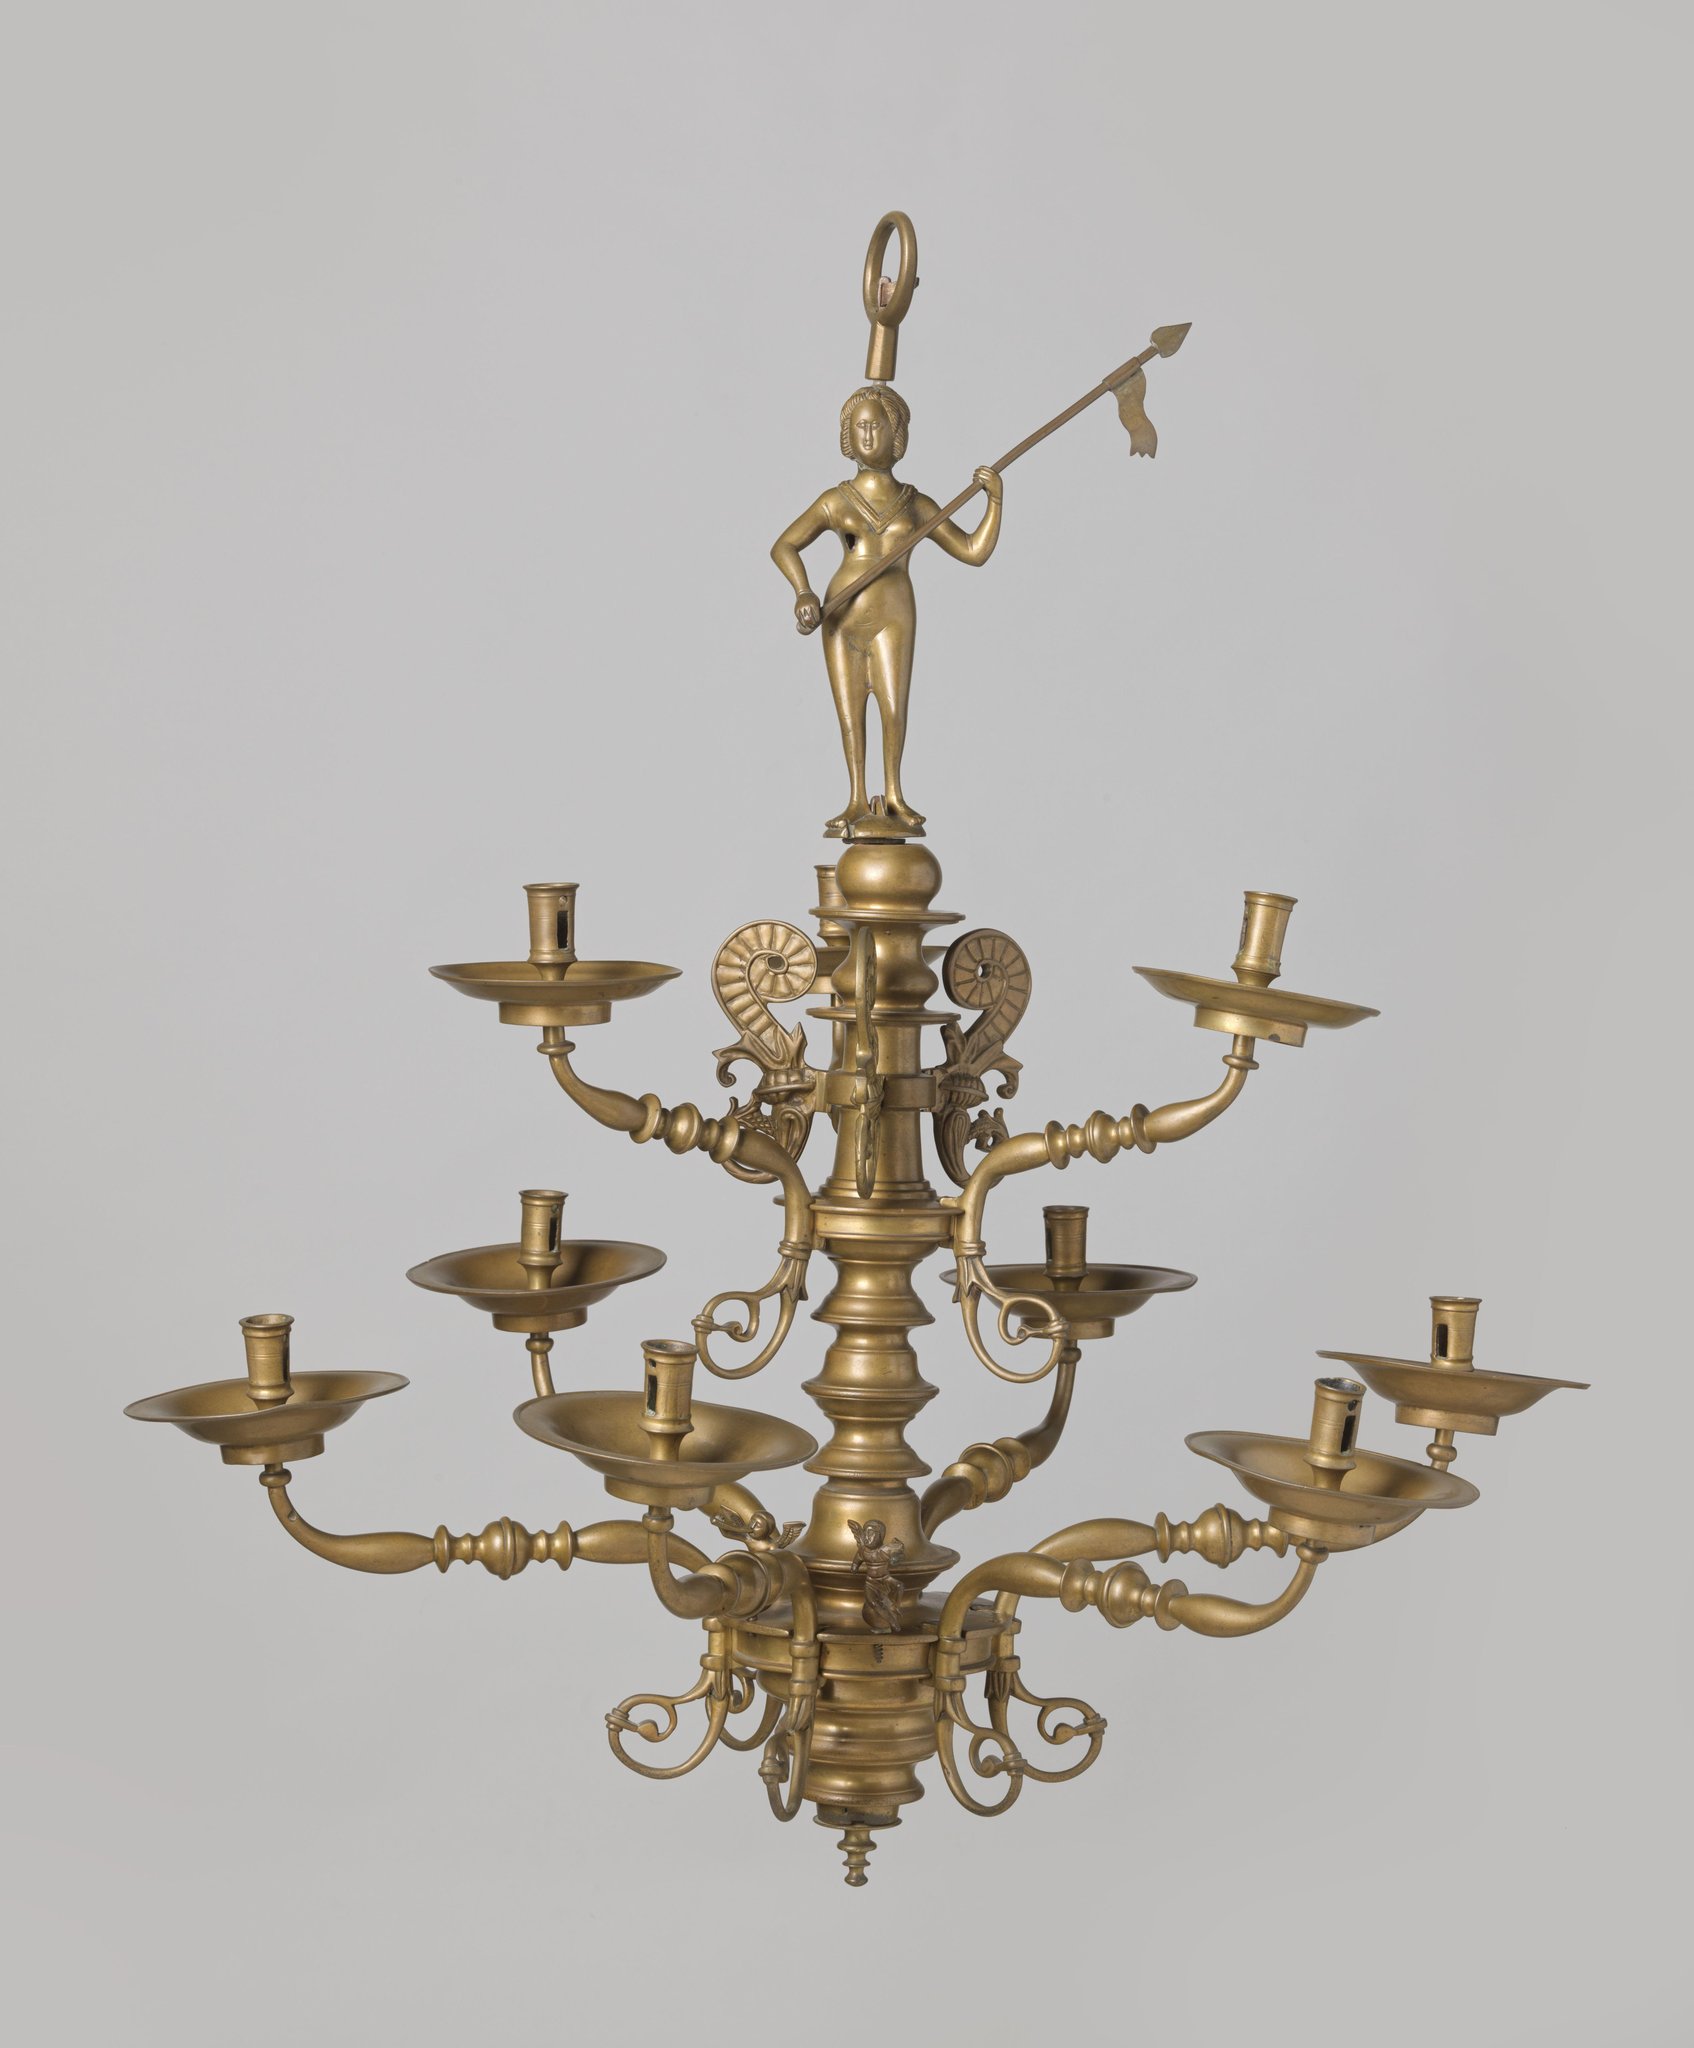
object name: chandelier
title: Arm met kaarsenhouder van kaarsenkroon van twee hoogten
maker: Anonymous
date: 1525-1575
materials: brass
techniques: casting, screwed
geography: lübeck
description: Kaarsenarm behorende bij een kaarsenkroon van twee hoogten met naakte vrouw bovenaan. De arm heeft in het midden een bol- en holrond geprofileerde nodus en verdikt zich een weinig aan weerszijden. Bij de stam loopt zij uit in een spiraalvormige krul. Naar buiten toe mondt zij uit in het schroefeind van ijzer. Daarop bevindt zich de ronde vetvanger met onderaan een afstaande rand. De ronde in elkaars verlengde opengewerkte kaarsenhouder heeft een holronde voet, die op de arm is geschroefd. Dit is de eerste arm van de onderste ring. De arm en de kaarsenhouder zijn ongenummerd.